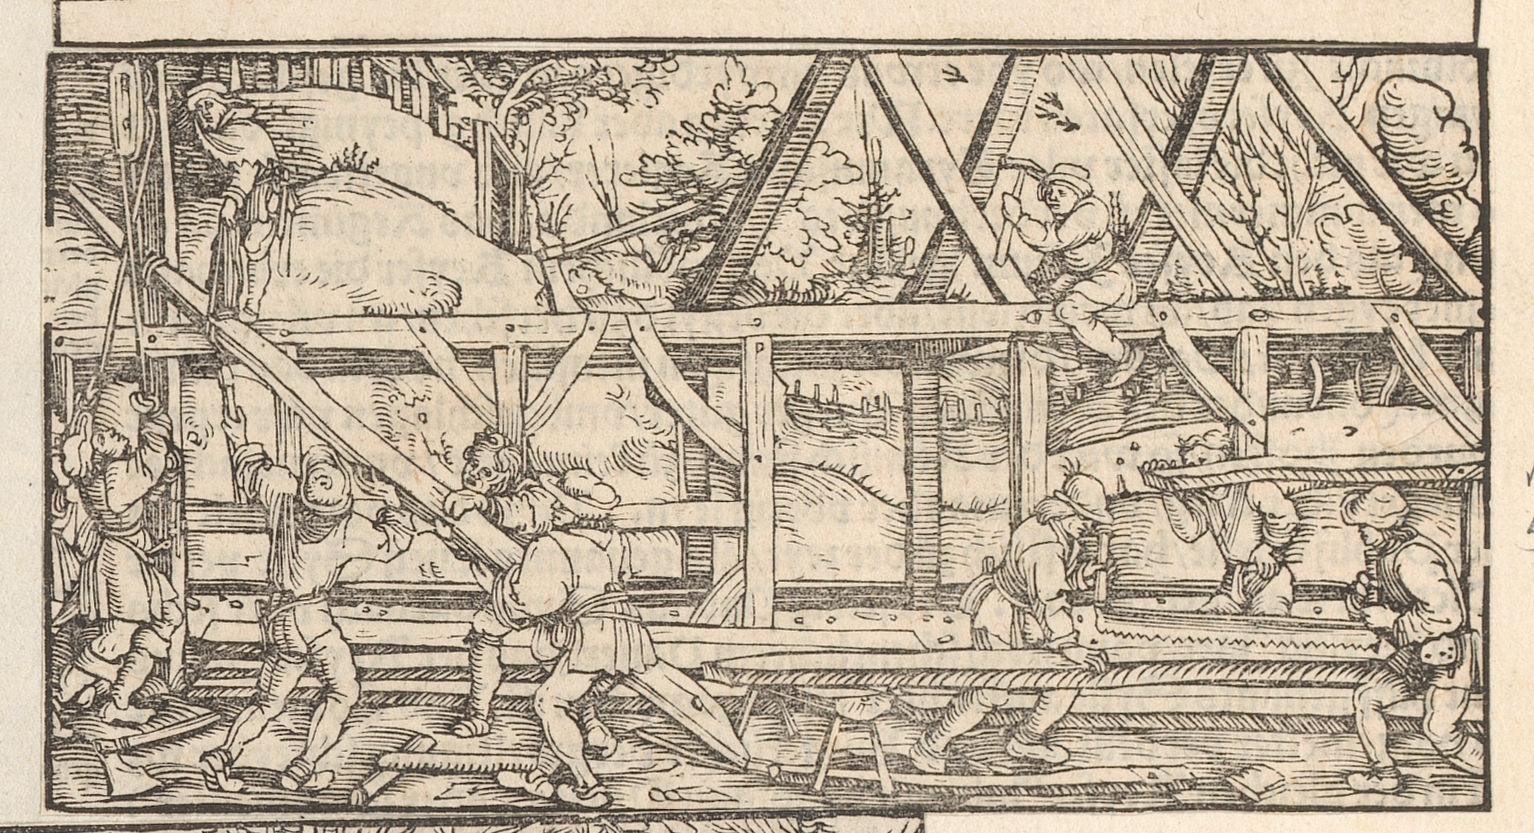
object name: book illustration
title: Timmermannen bouwen een huis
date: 1514-1531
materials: paper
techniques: letterpress printing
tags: carpenter, timber framing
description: Deze prent is gebruikt in: Cicero, Marcus Tulius. Officia M.T.C. Ein Buch so Marcus Tullius Cicero der Römer zu seynem (...). [Vertaald uit het Latijn door] Johann von Schwarzenberg. Augsburg: Heinrich Steiner, 1531.